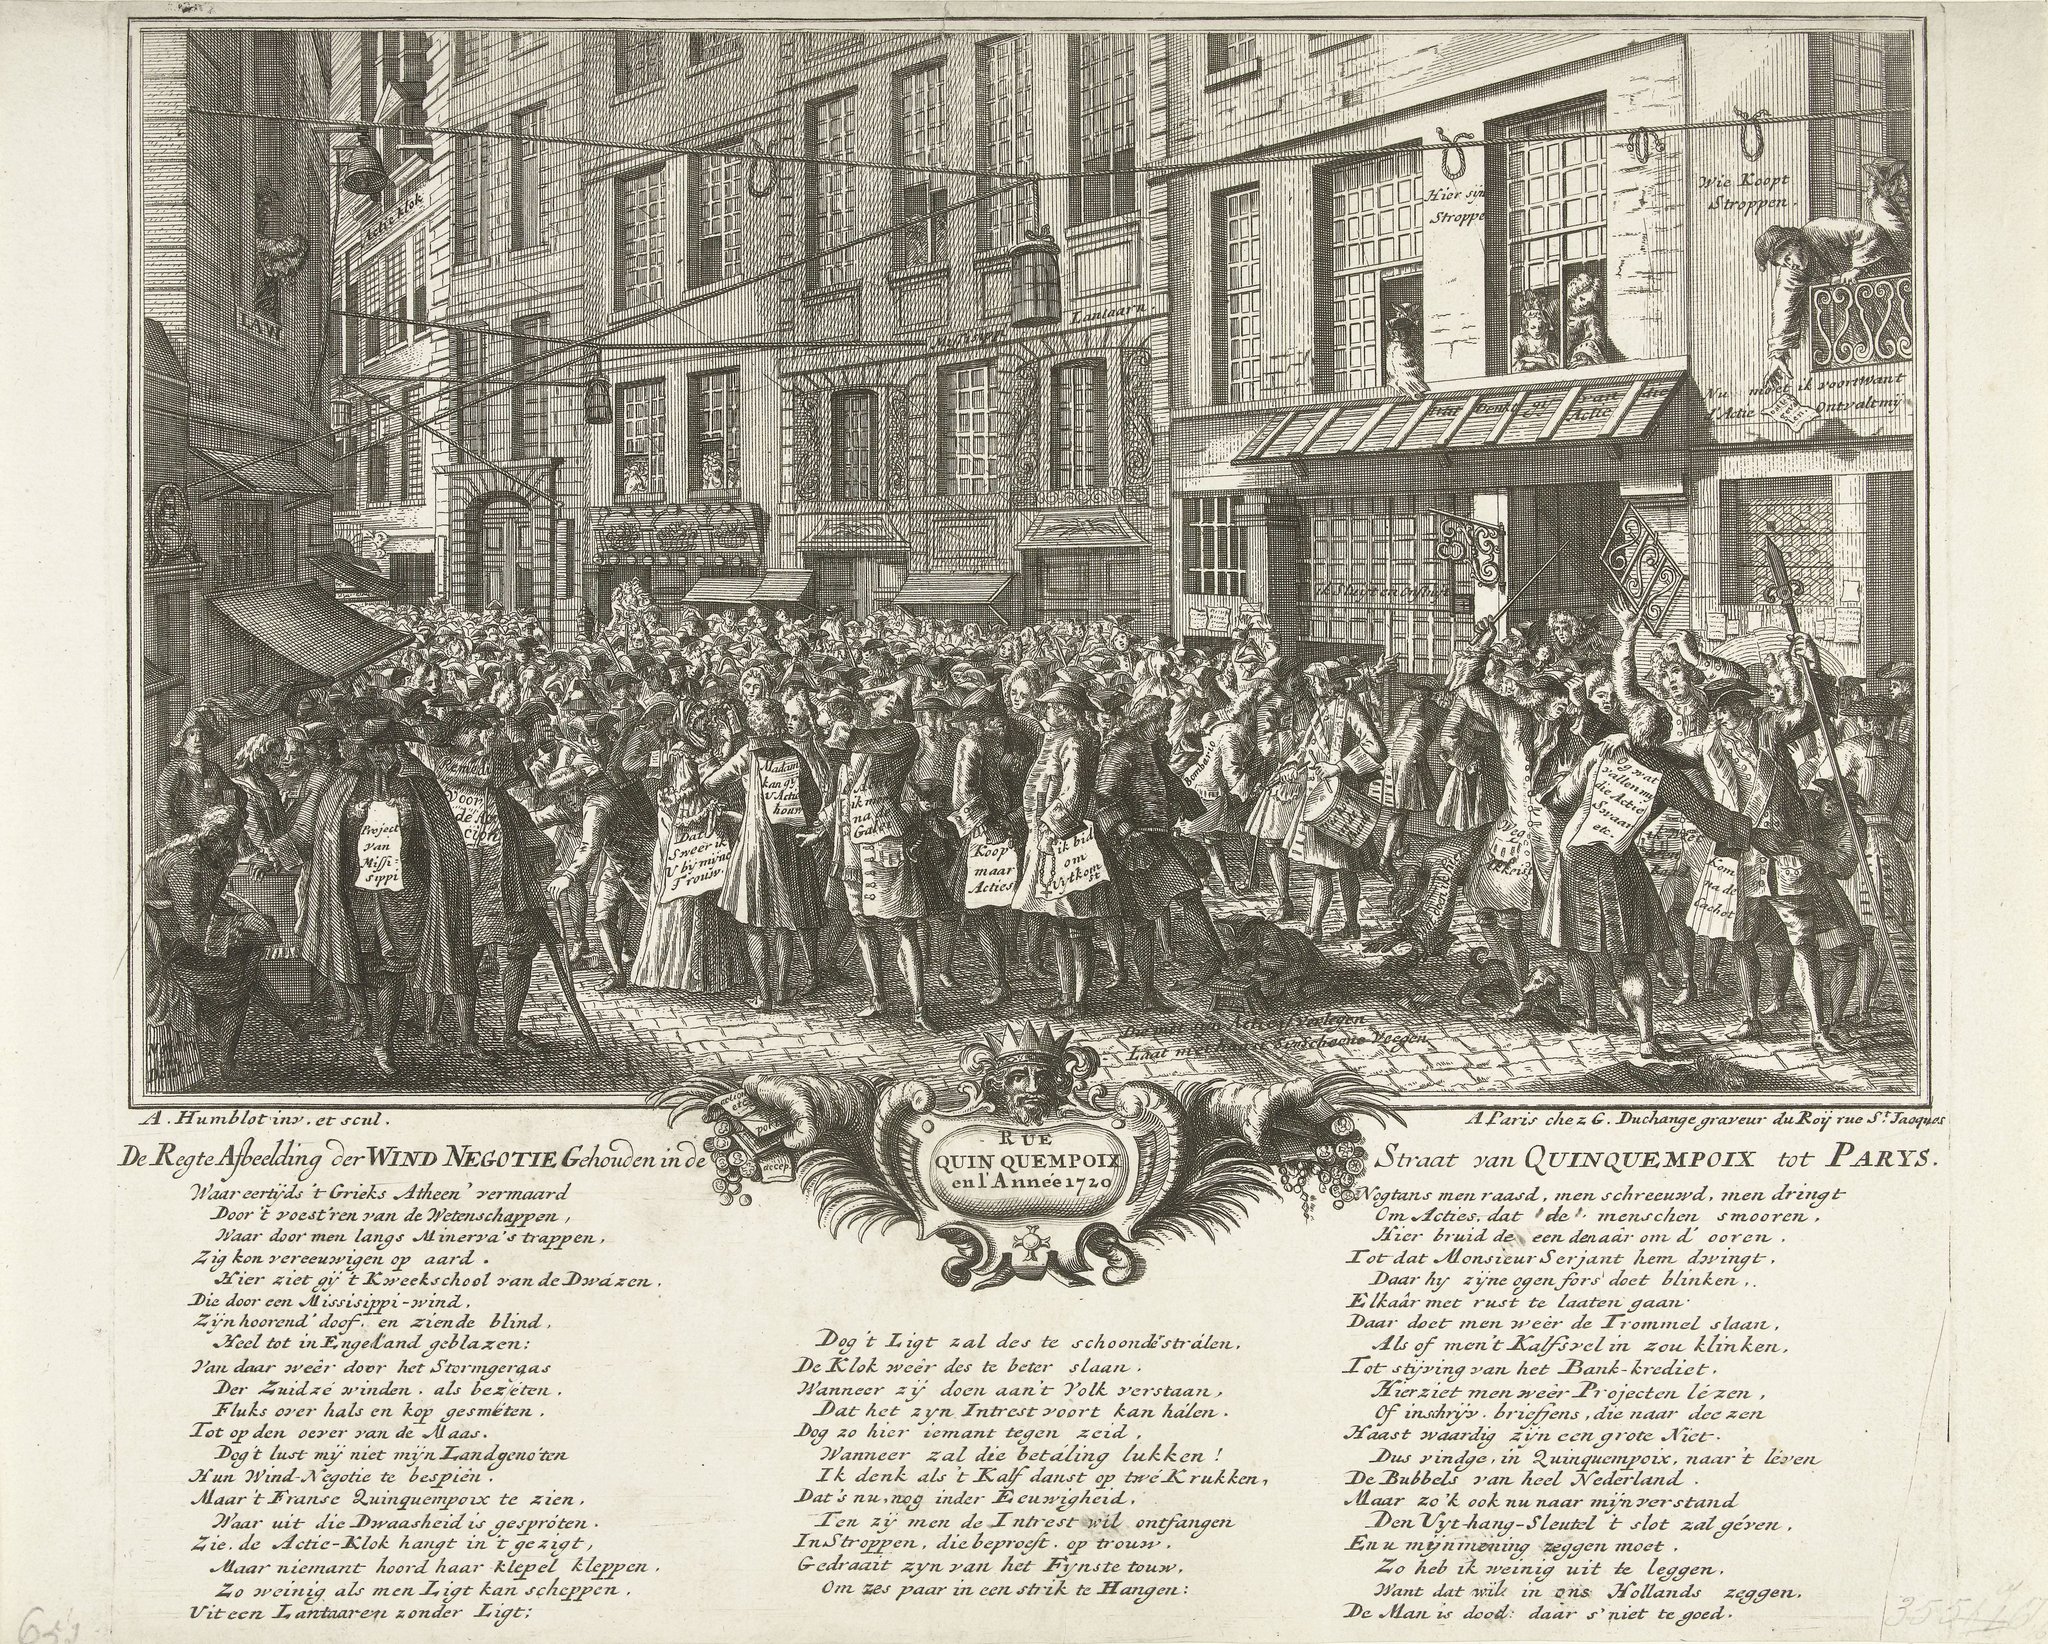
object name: cartoon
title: Windhandel in de Rue Quinquempoix, 1720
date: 1720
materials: paper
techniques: etching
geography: northern netherlands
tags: financial panic, street-fights, riots, paris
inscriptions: collector's mark: Lugt 2228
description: Spotprent op de windhandel in de Rue Quinquempoix te Parijs waar deze handel voornamelijk gedreven werd. Opstootjes op straat tussen handelaren en geruïneerde kopers. In het onderschrift een vers in drie kolommen, met opschriften in het Nederlands in de plaat. Prent 16 in de serie Het Groote Tafereel der Dwaasheid met spotprenten op de Windhandel of Actiehandel van 1720.